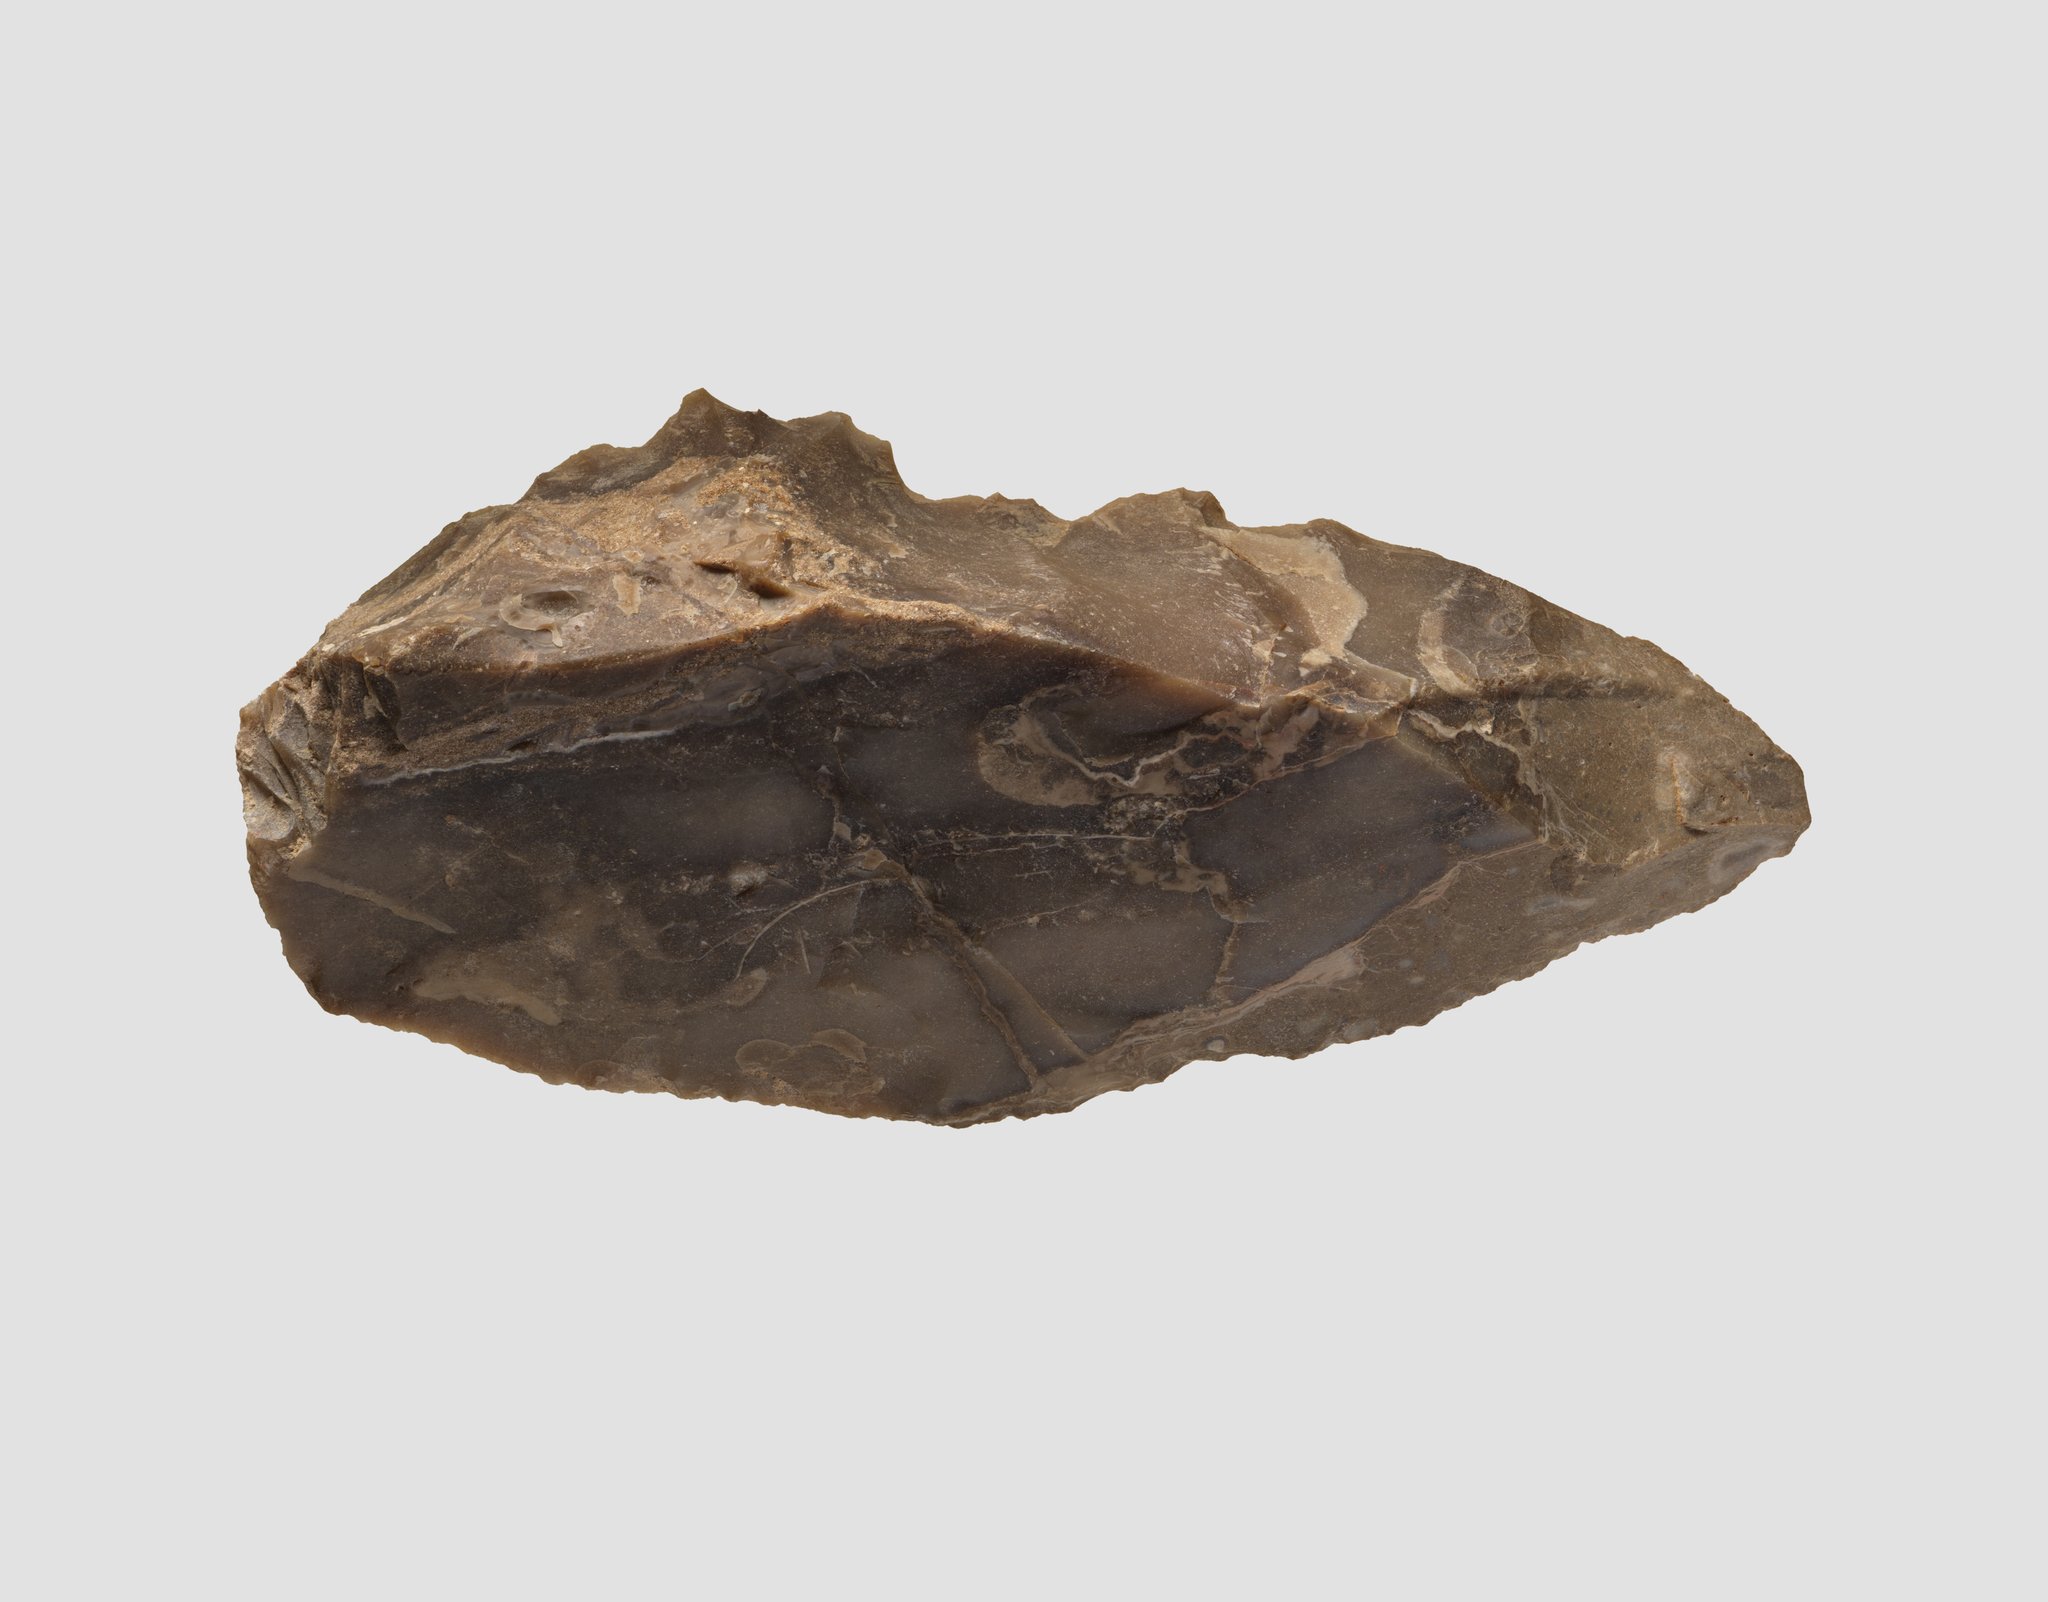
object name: knife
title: Blade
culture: ghassulian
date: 4600-3600 BCE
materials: stone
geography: levant